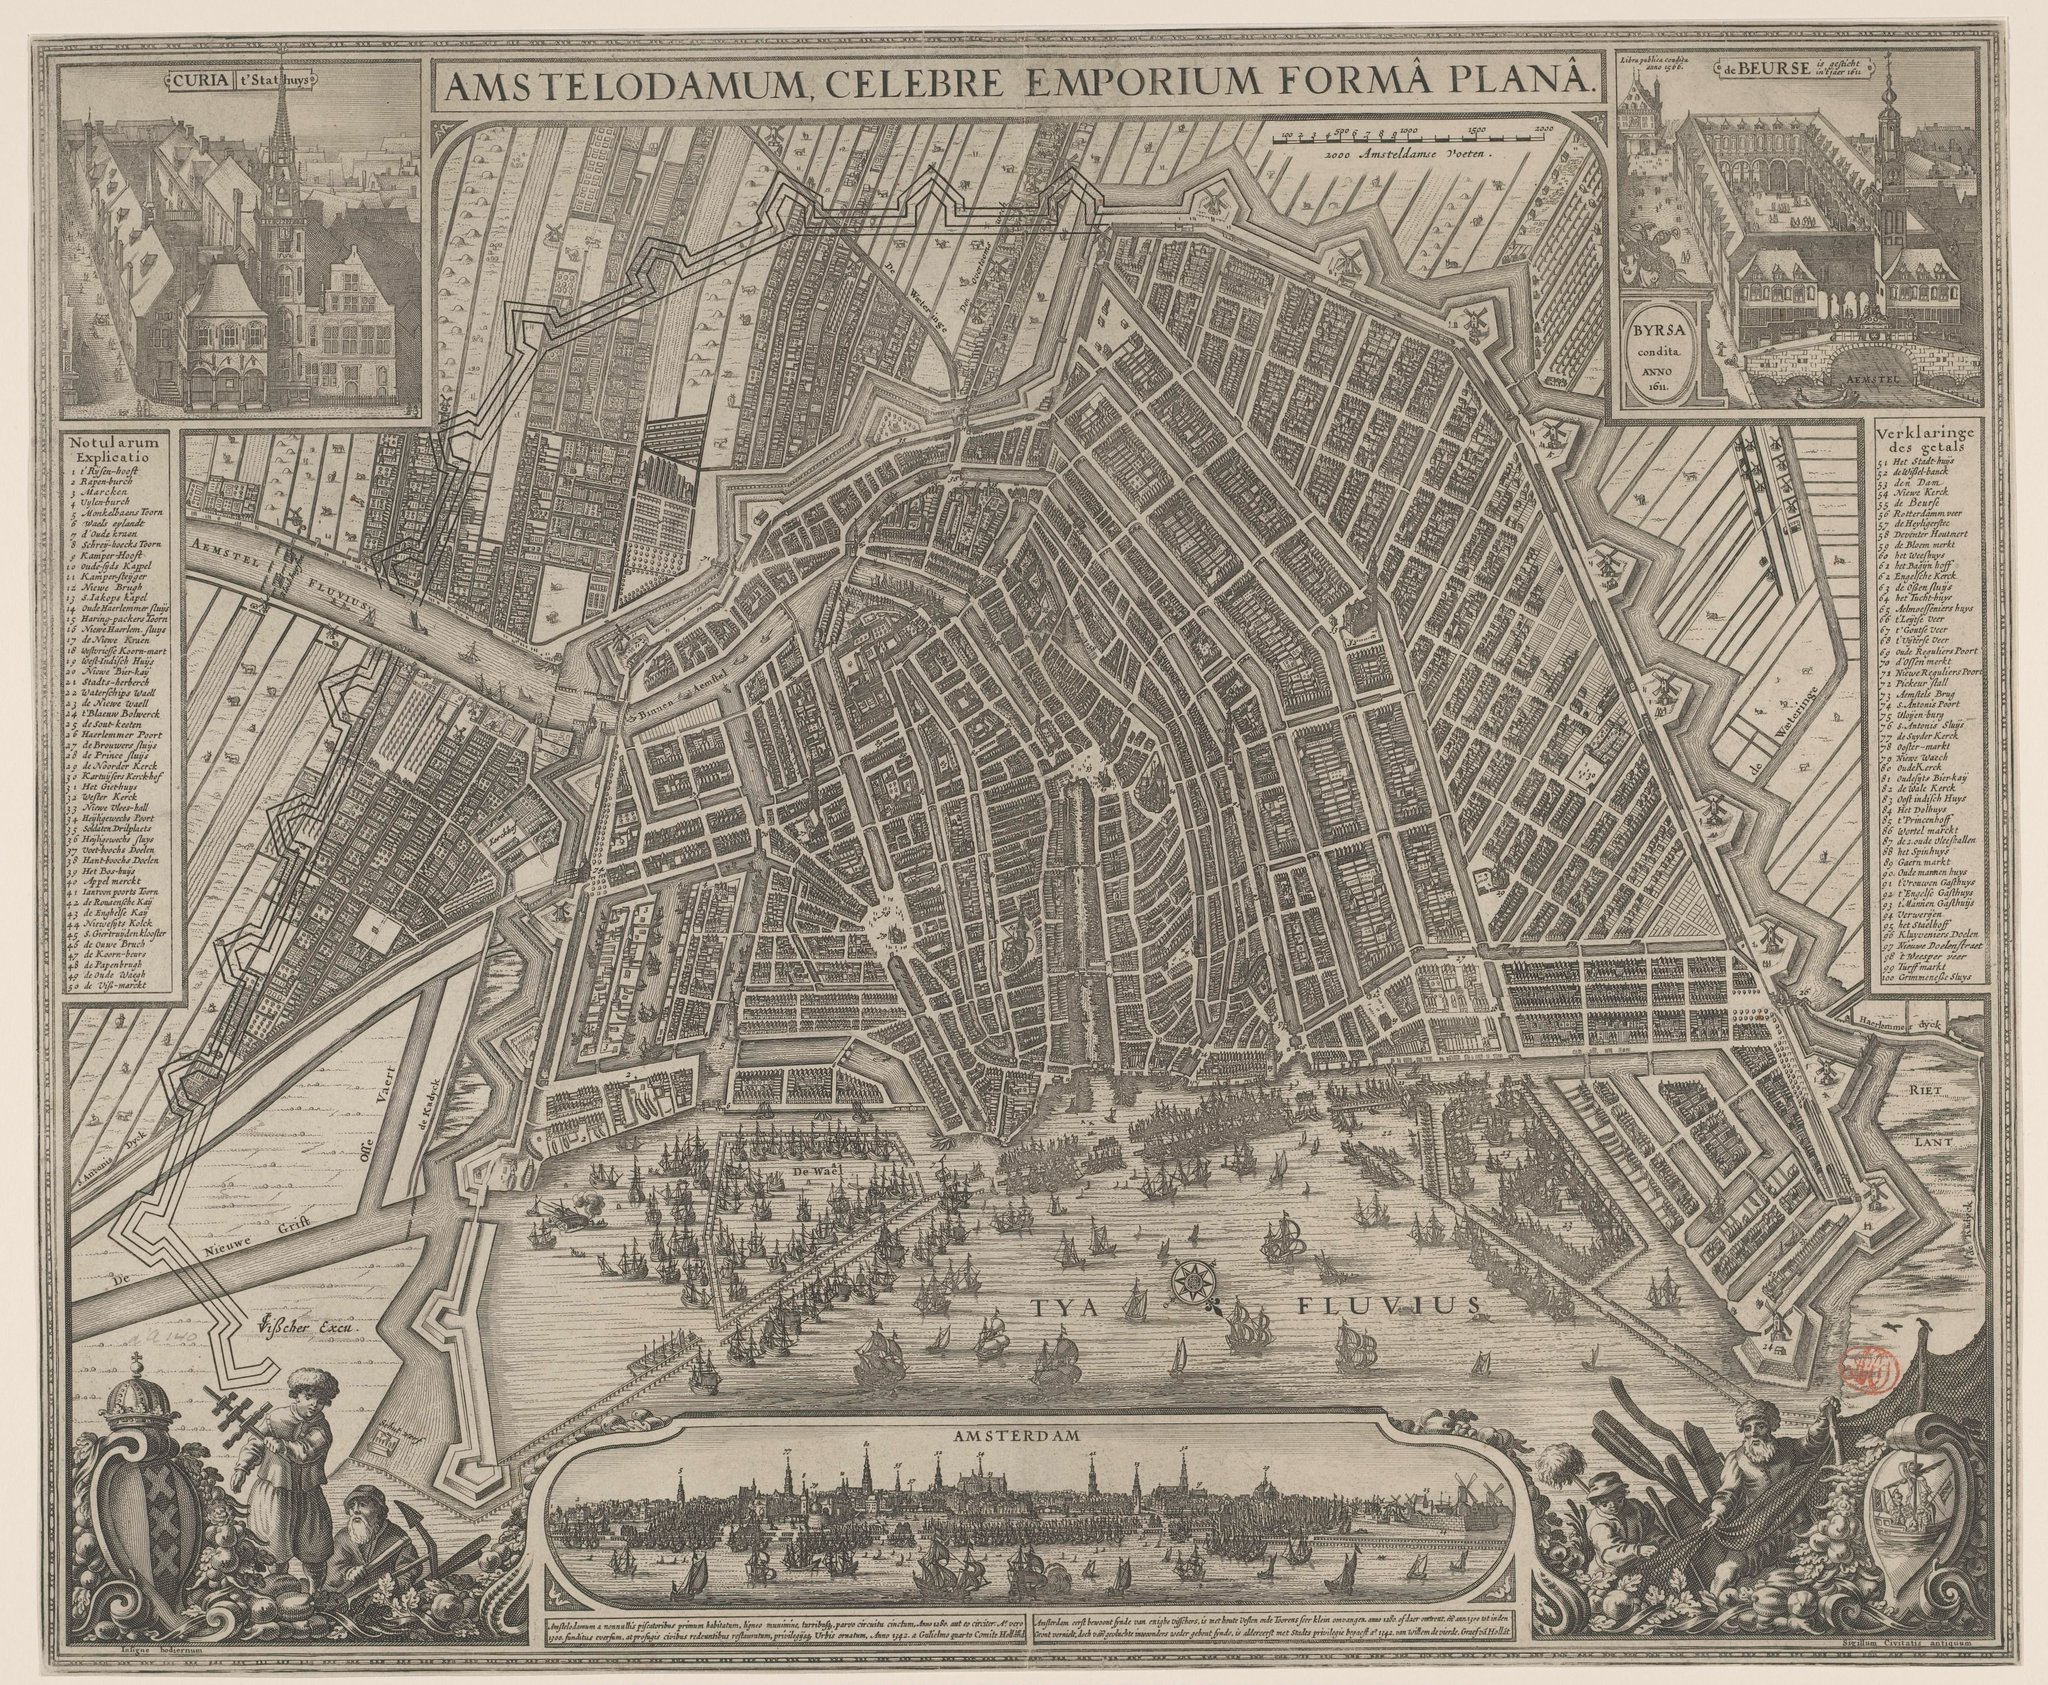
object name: area plan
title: Amstelodamum, celebre emporium formâ planâ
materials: paper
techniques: engraving, etching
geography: amsterdam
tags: coat of arms (as symbol of the state, etc.) (+ city; municipal), townhall, seaman, parts of ship's exterior: anchor, maps of cities, position-finding at sea; nautical instruments, exchange, bourse, prospect of city, town panorama, silhouette of city, fisherman, binoculars, spy-glass, etc., amsterdam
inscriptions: collector's mark: Lugt 195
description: Plattegrond in vogelvluchtperspectief. Op de linkerhelft is het ontwerp voor nieuw aan te leggen bolwerken (voor de Vierde Uitleg) te zien. Linksboven een gezicht op het Oude Stadhuis op de Dam, daaronder de legenda 1-50. Boven in het midden te titel. Rechtsboven een gezicht op de Beurs, daaronder de legenda 51-100. Links daarvan een schaalstok: 2000 Amsteldamse Voeten. Linksonder het wapen van de stad en twee figuren, waarschijnlijk zeemannen (de een heeft een jacobsstaf vast en de ander een anker en een verrekijker). Onder in het midden een gezicht op de stad met daaronder informatie in het Latijn en Nederlands. Rechts twee vissers en het stadszegel. Oriëntatie: zuidzuidwest boven.